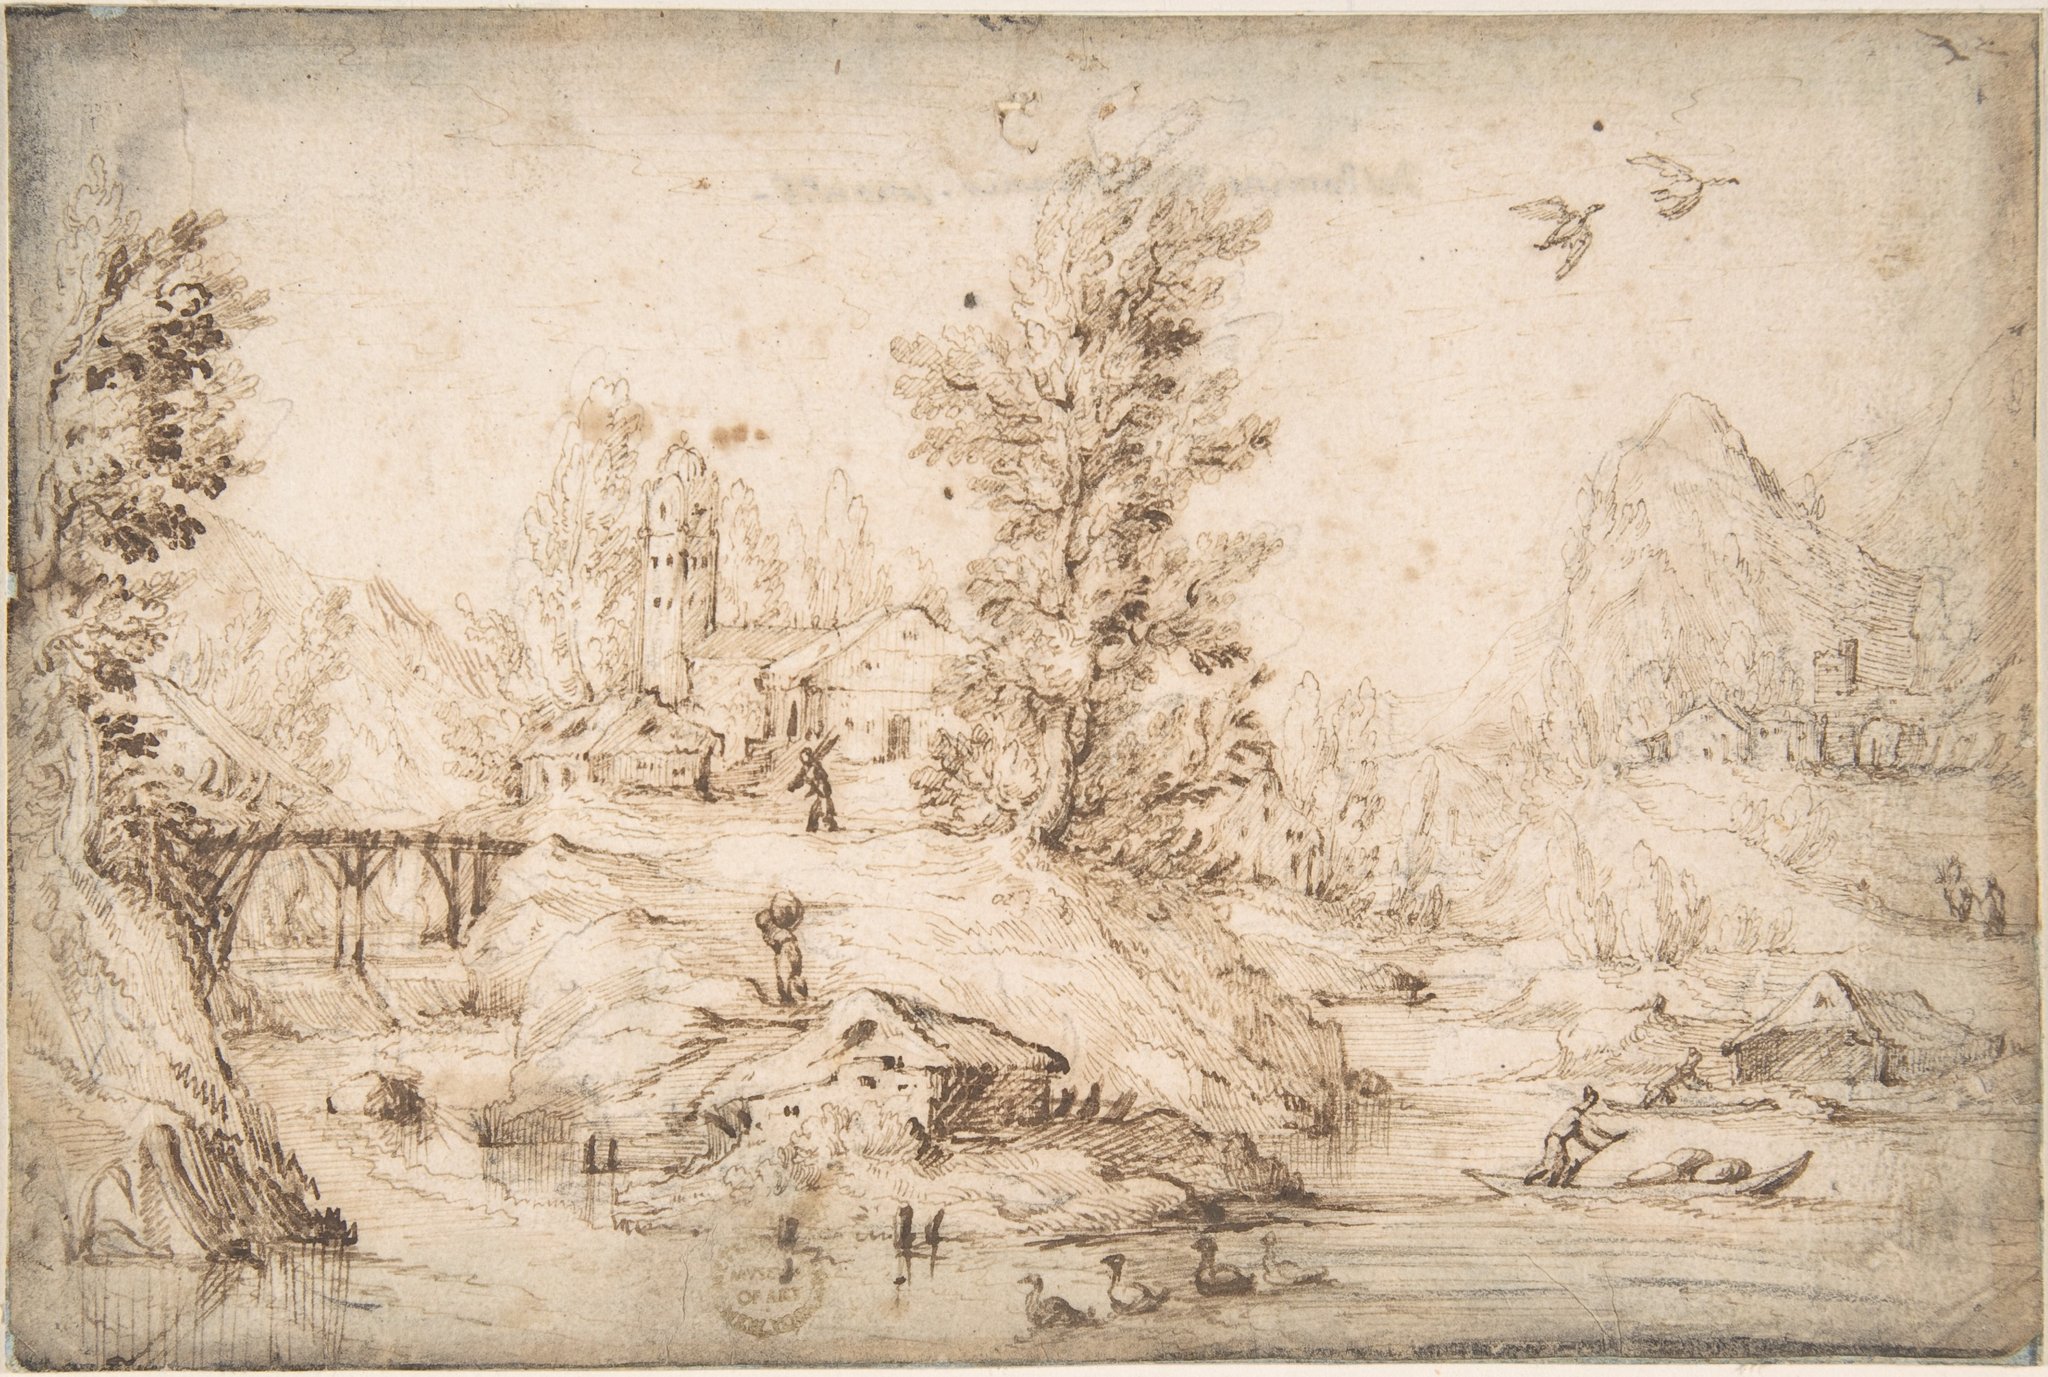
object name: drawing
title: River View with Figures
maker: anonymous, italian, roman-bolognese, 17th century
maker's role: artist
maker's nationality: italian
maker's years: 1600-1700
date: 1601-1700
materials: chalk, ink, paper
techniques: pen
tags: human figures,ducks,houses,rivers,landscapes,boats